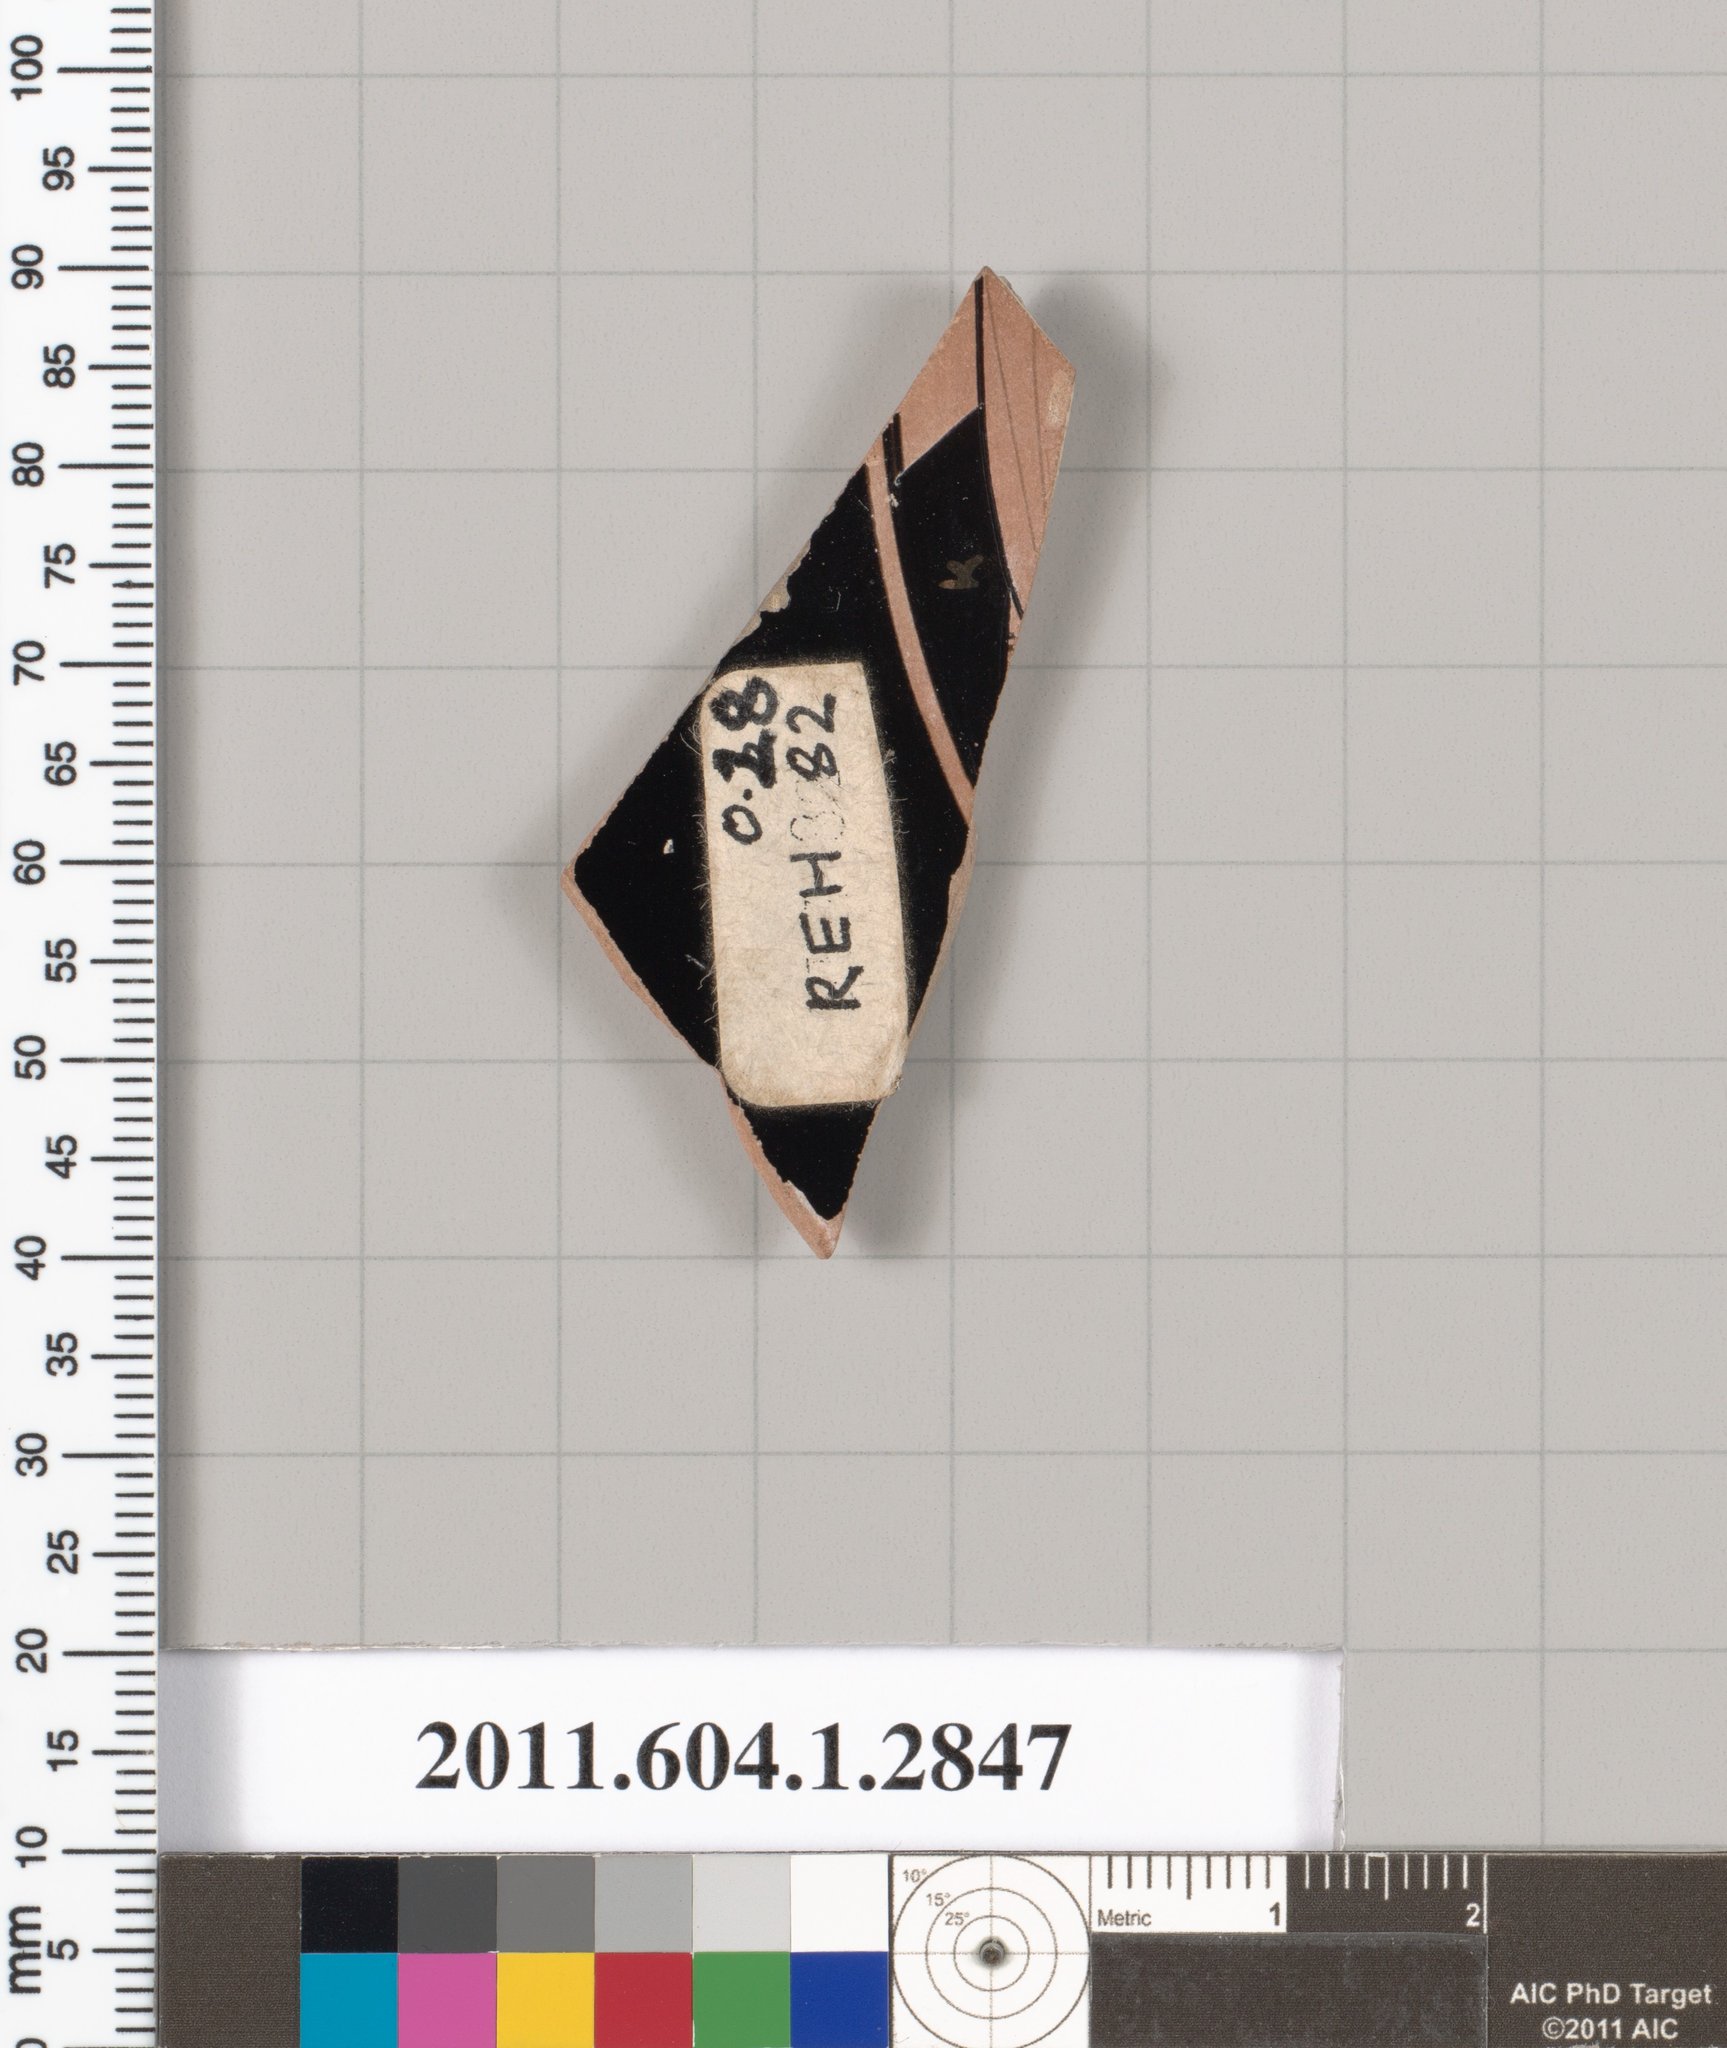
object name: kylix fragment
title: Terracotta fragment of a kylix (drinking cup)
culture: greek, attic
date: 520-500 BCE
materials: terracotta